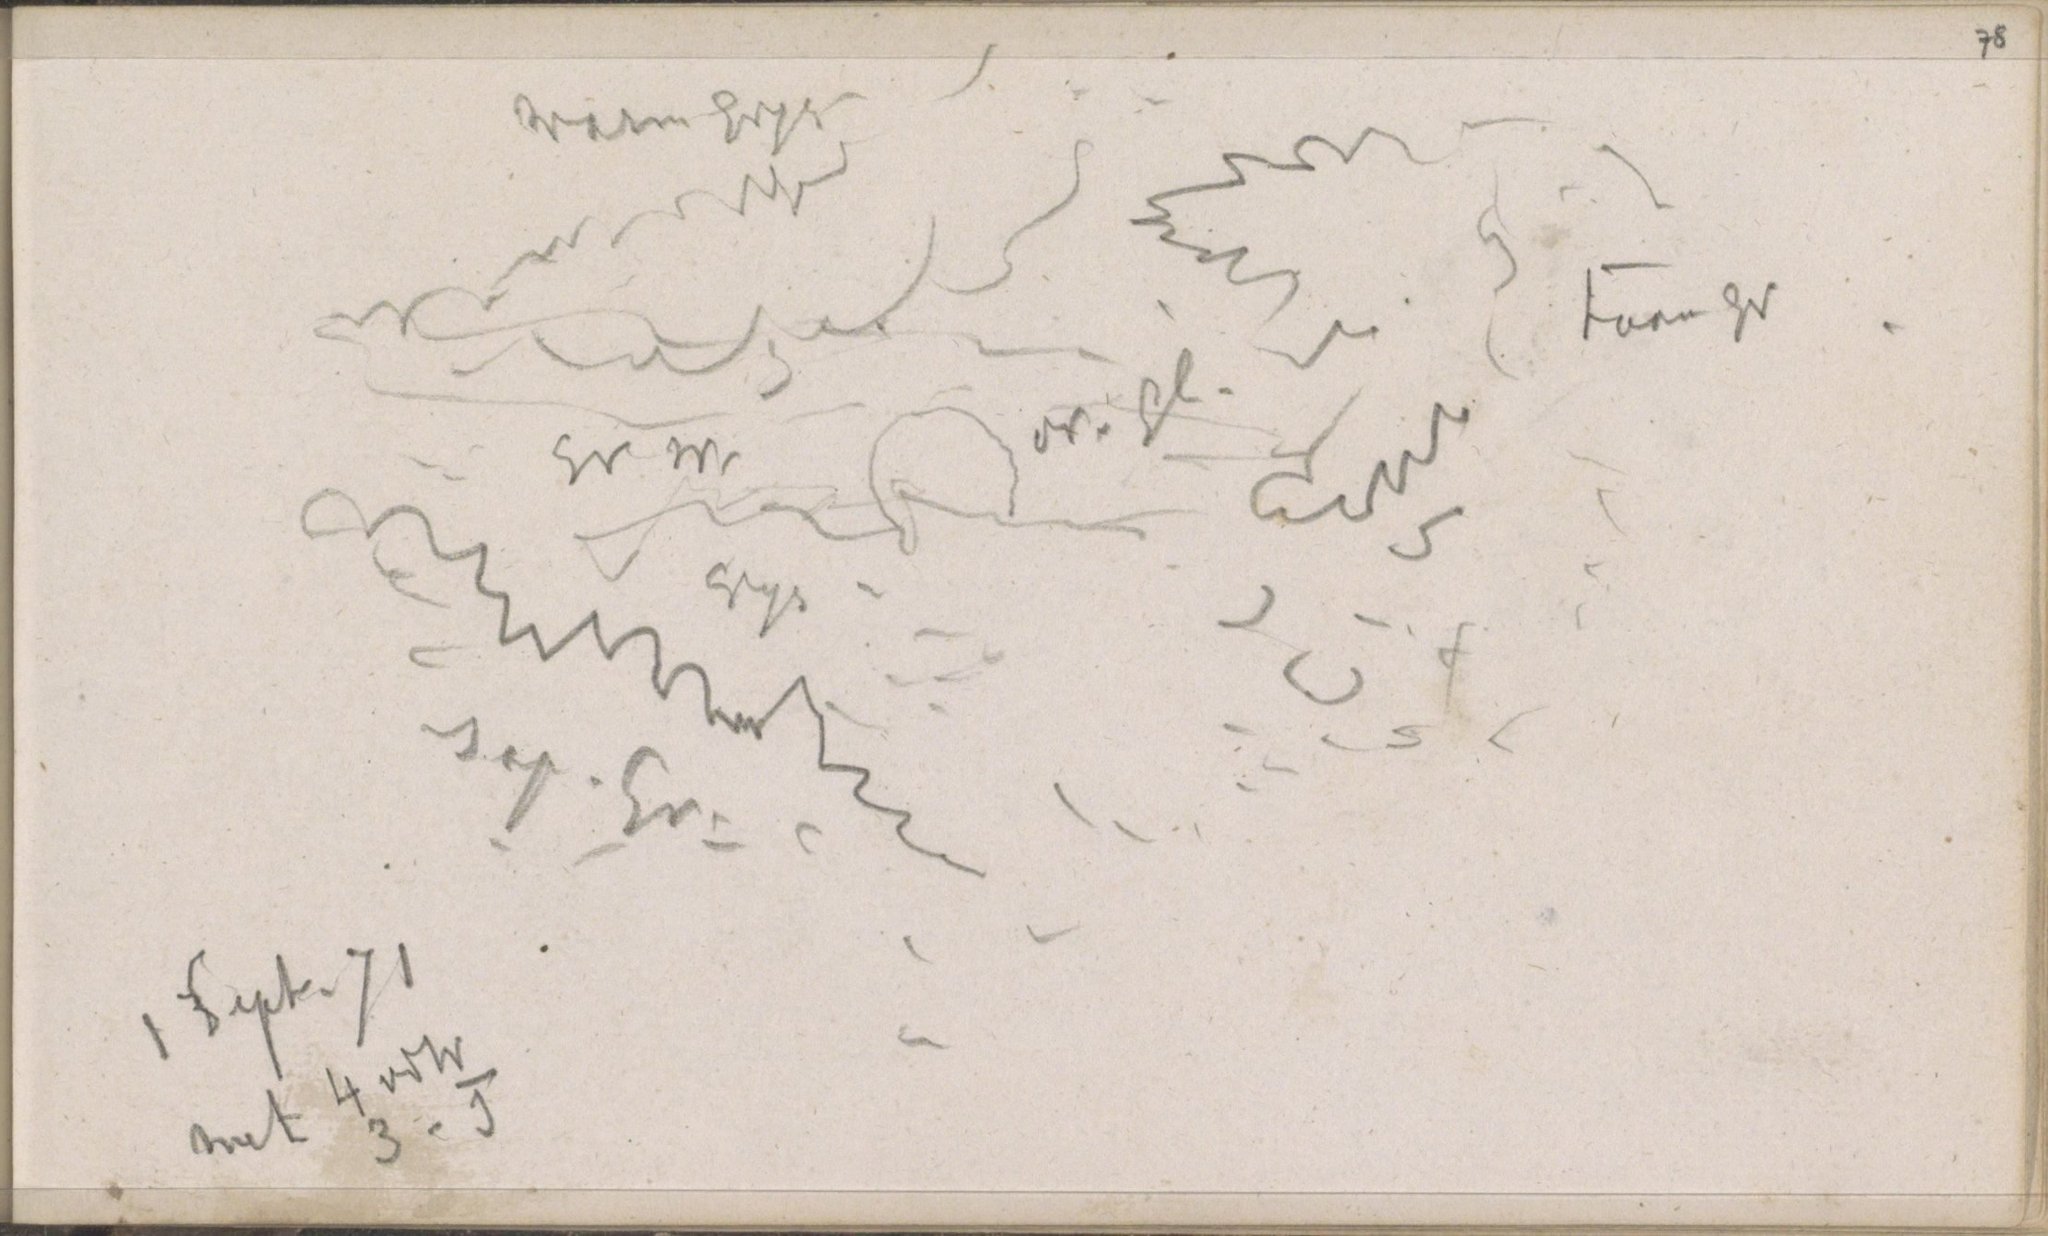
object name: sketchbook leaf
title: Landschap met bomen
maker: johannes tavenraat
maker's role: draughtsman, painter, print maker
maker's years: 1809-1881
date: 1809-1871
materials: paper, pencil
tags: trees, landscapes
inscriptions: date and inscription: ‘1 Sept 71/ met 4 vdW/ 3.J’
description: Blad 78 recto uit een schetsboek met 98 bladen.